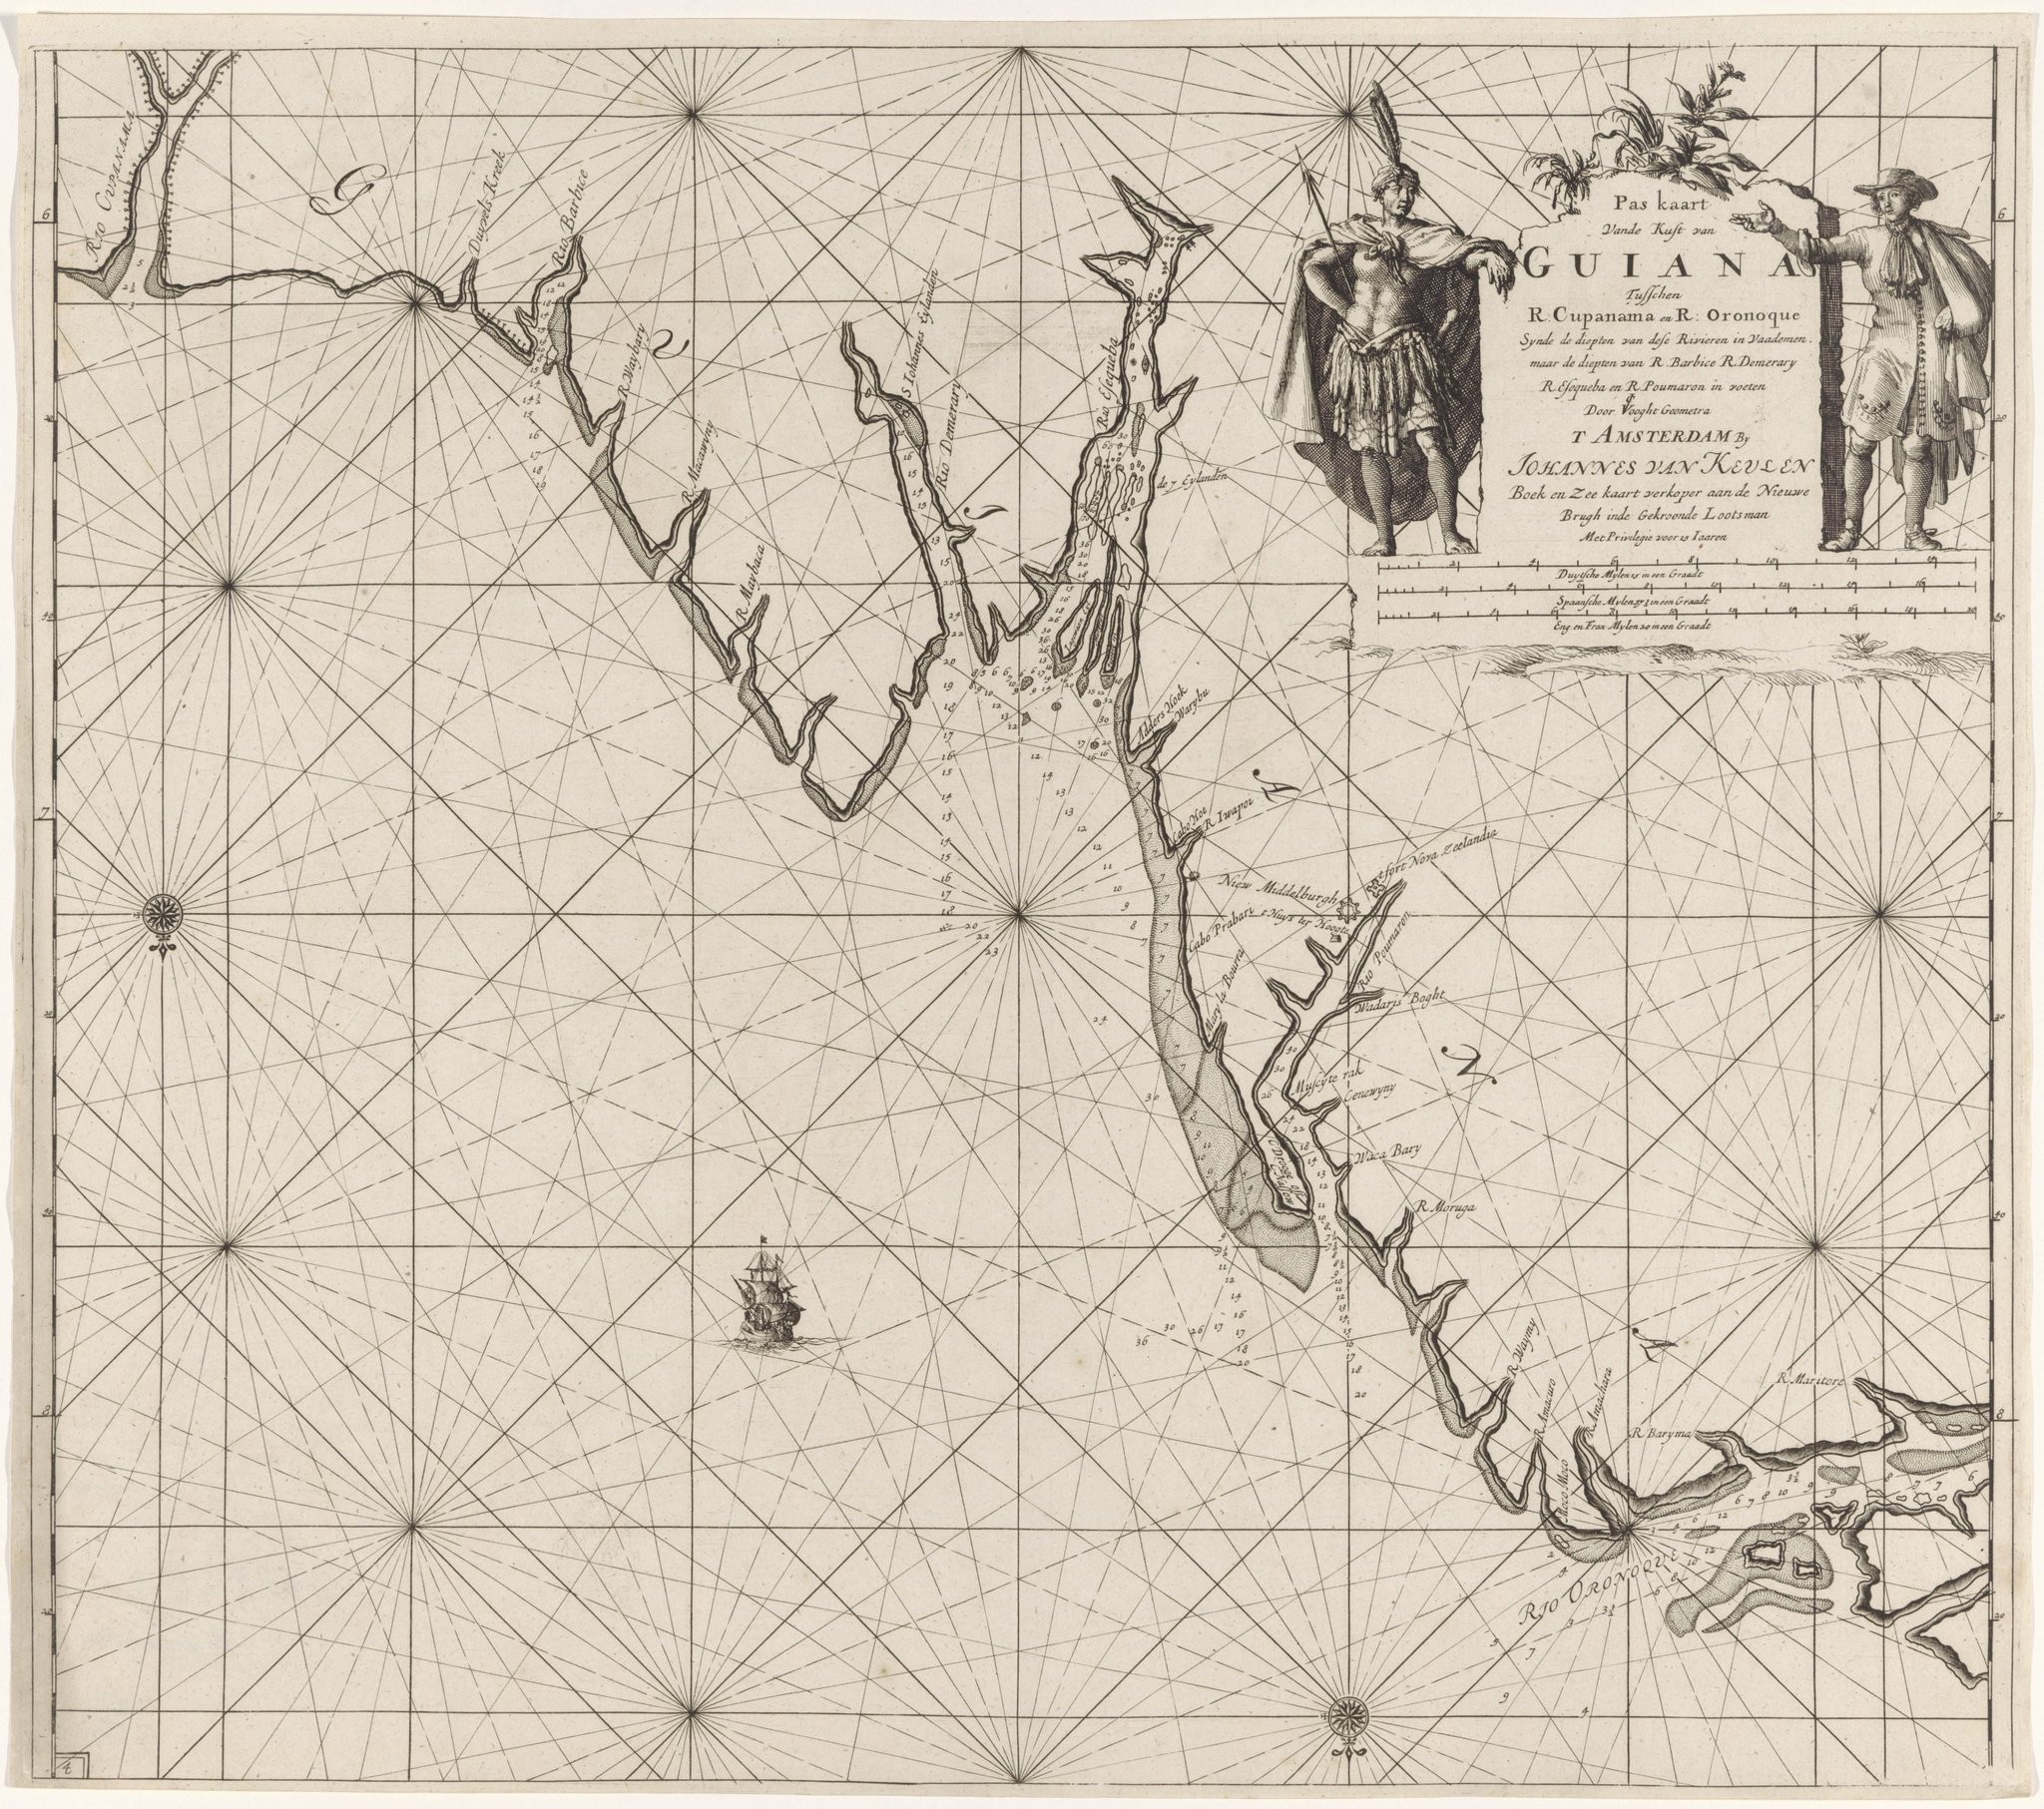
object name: print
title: Paskaart van een deel van de kust van Suriname en Guyana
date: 1684-1799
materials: paper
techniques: engraving, etching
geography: amsterdam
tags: sailing-ship, sailing-boat, indigenous peoples of south america, merchant, salesman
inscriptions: collector's mark: Lugt 2228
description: Paskaart van een deel van de kust van Suriname en Guyana, met twee kompasrozen, het Noorden ligt onder. Rechtsboven de titel, het adres van de uitgever en de schaalverdeling, weergegeven in Duitse, Spaanse en Engelse of Franse mijlen. De gegevens worden geflankeerd door een handelaar en een donkere man met een verentooi.